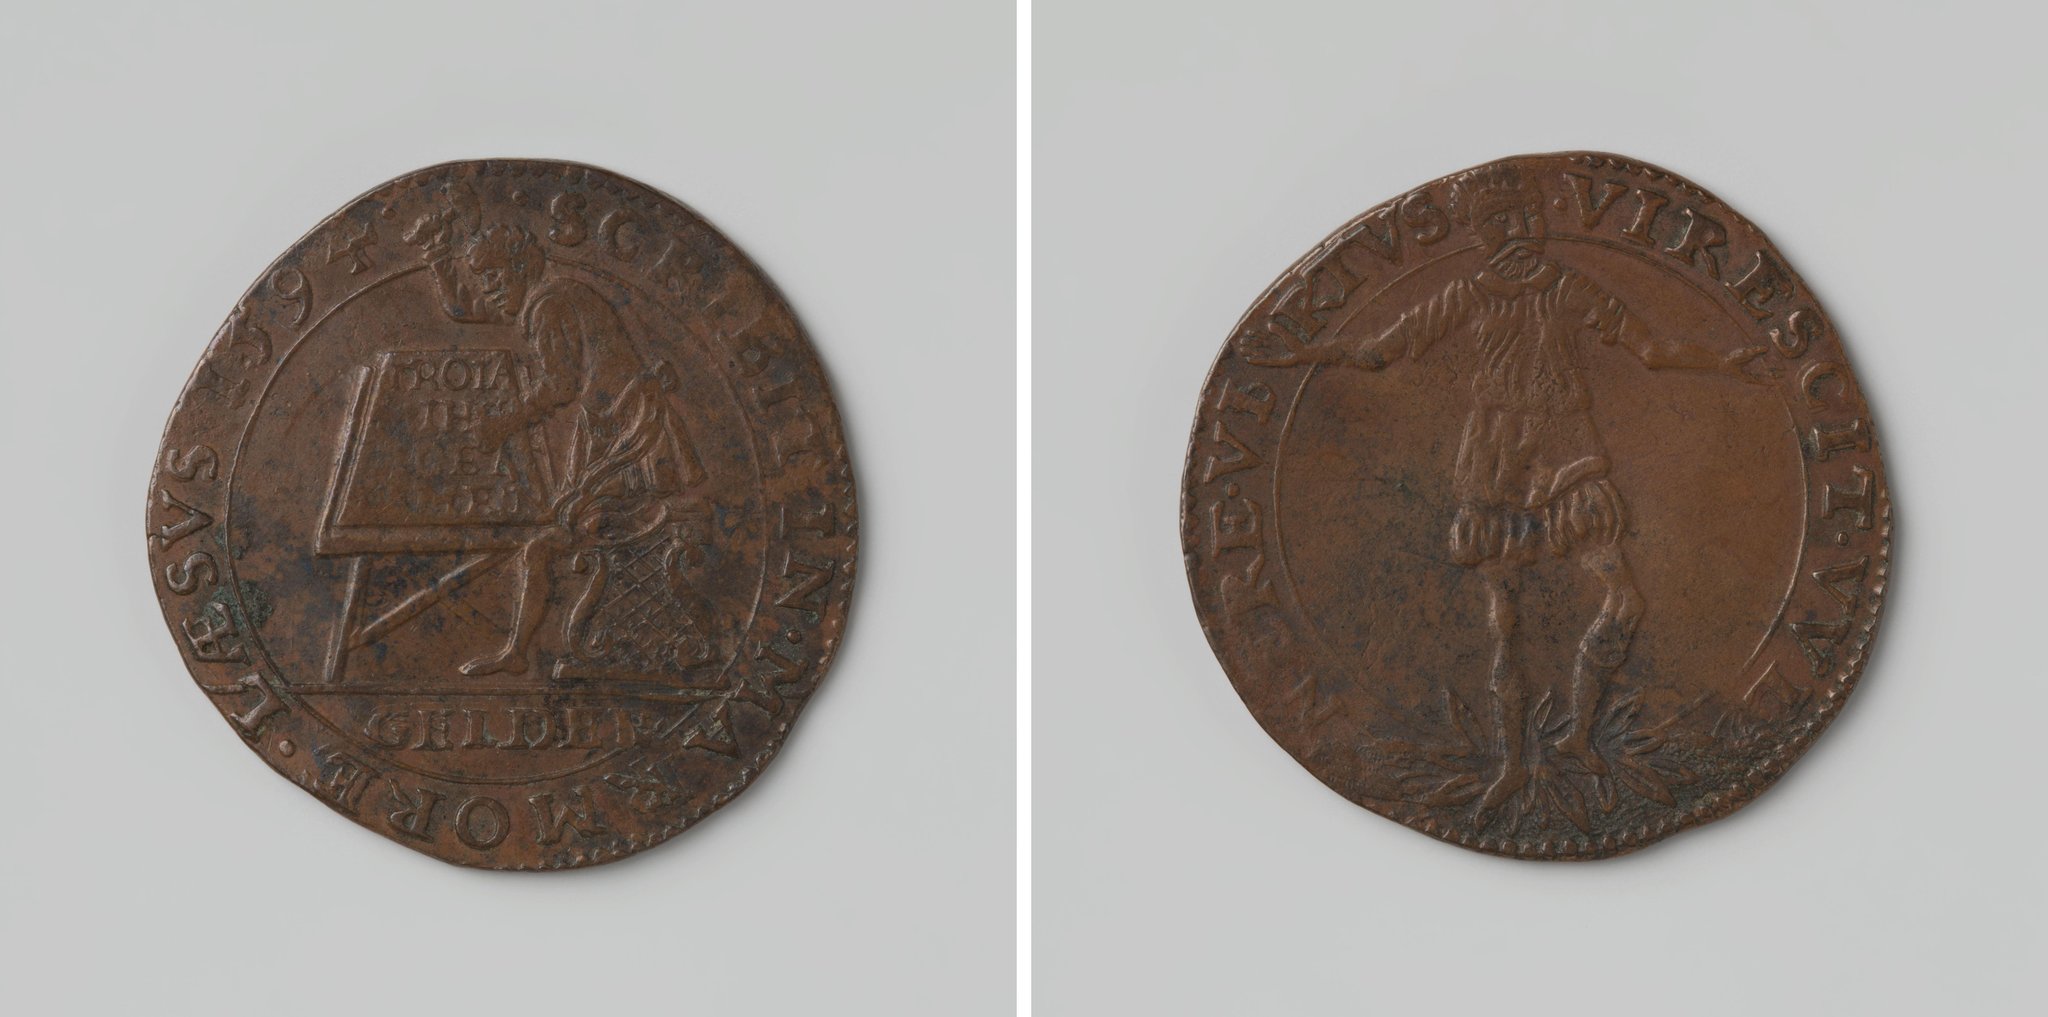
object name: jeton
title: Waarschuwing tegen de Spaanse vredesvoorstellen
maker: Anonymous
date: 1594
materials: copper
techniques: striking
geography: gelderland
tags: tachtigjarige oorlog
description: Koperen penning. Voorzijde: steenhouwer die tekst beitelt op een tafel binnen omschrift; afsnede: opschrift. Keerzijde: man in lompen gekleed vertrapt kamillestruiken binnen omschrift